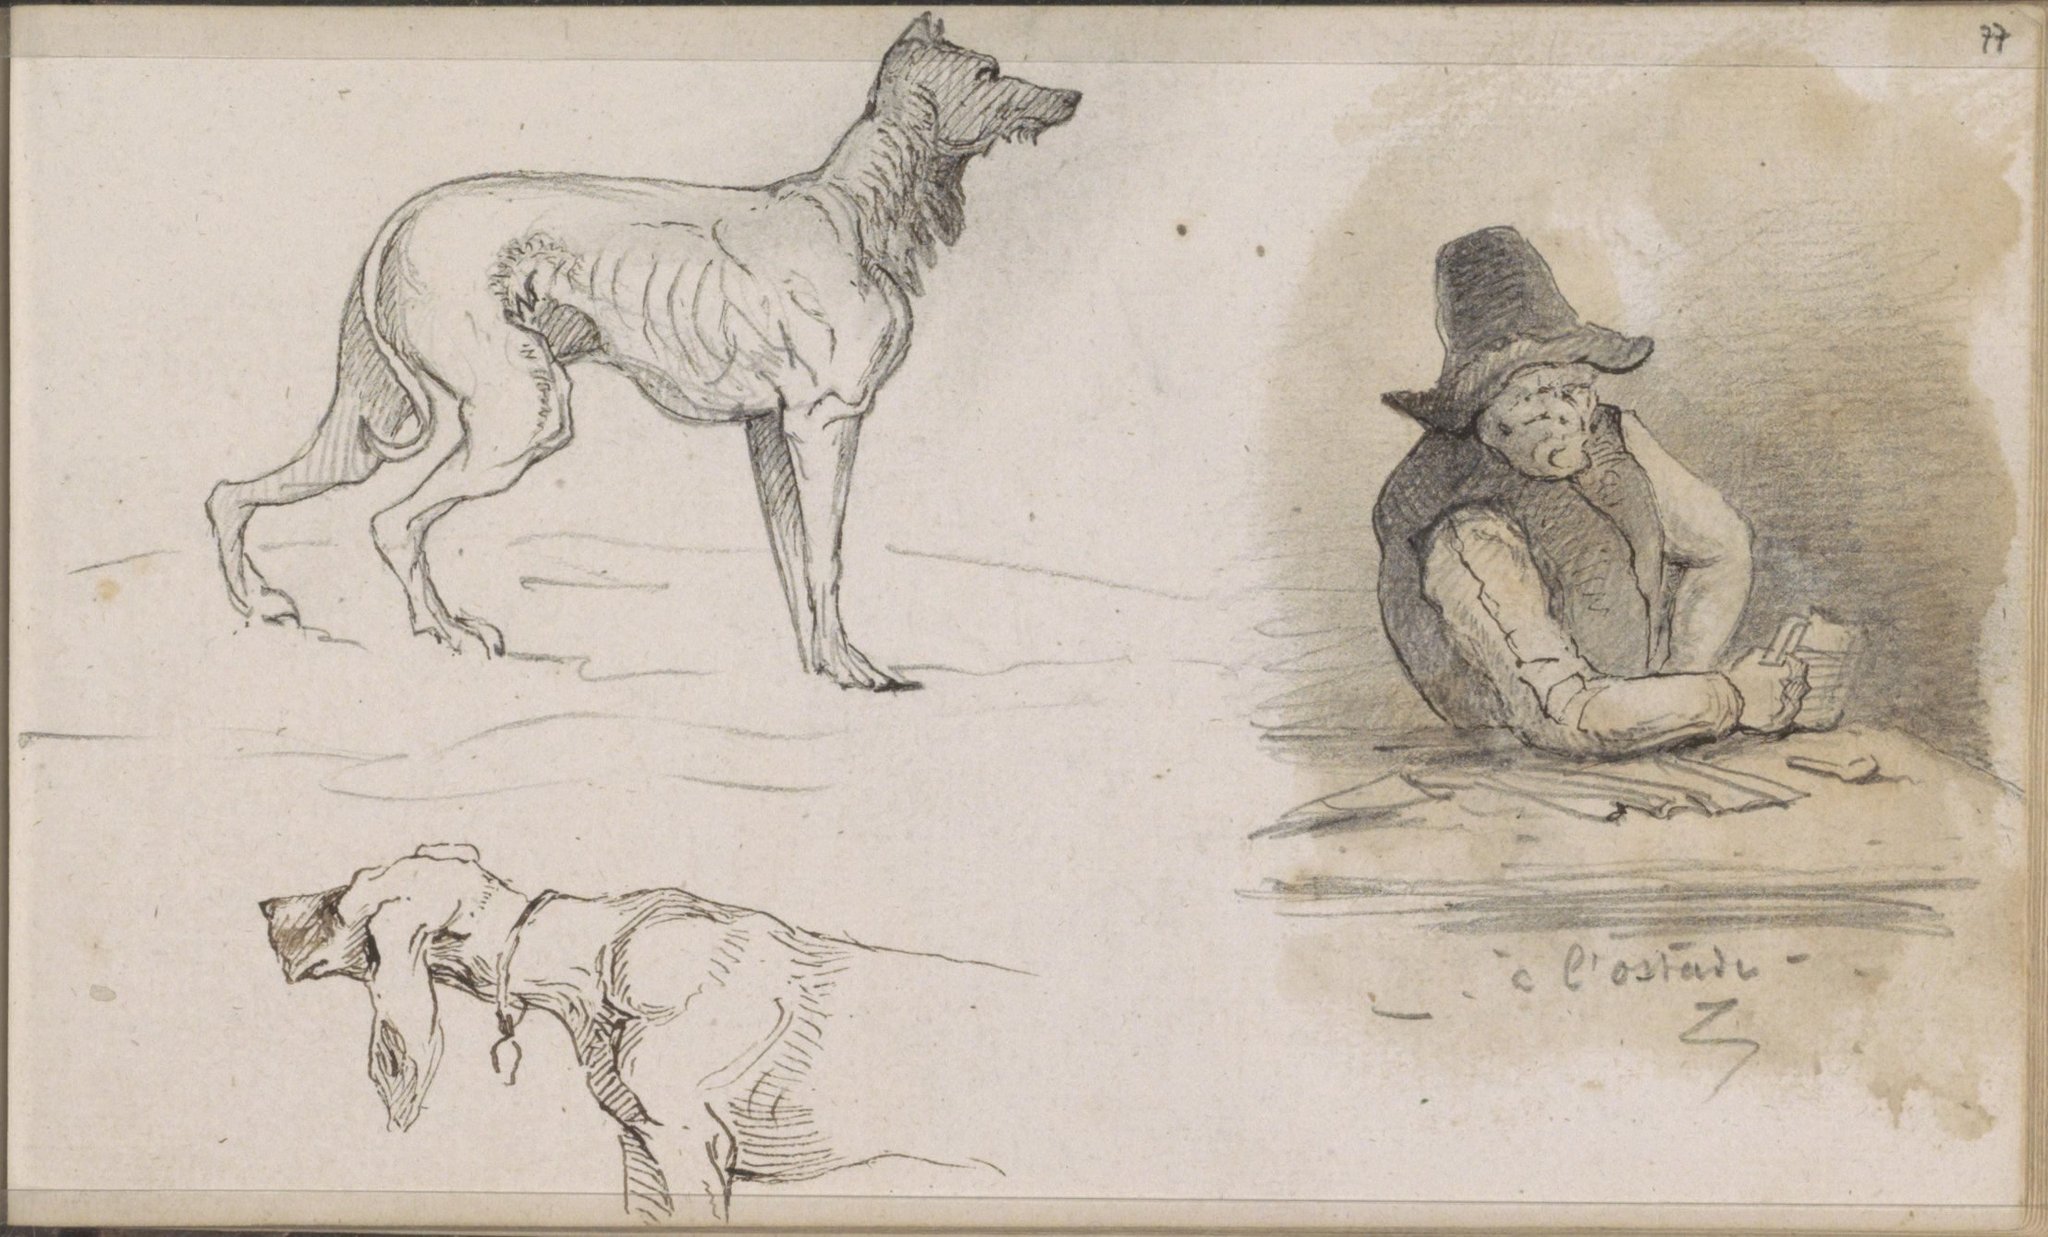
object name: sketchbook leaf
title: Honden en een man leunend op een tafel met een kroes in de hand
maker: johannes tavenraat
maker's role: draughtsman, painter, print maker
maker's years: 1809-1881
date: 1864-1880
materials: ink, paper, pencil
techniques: brush, pen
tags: adult man, mug, beaker, goblet, leaning figure, dog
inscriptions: annotation: ‘a l'ostade’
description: De schets van de man met de kroes in de hand is een kopie naar een werk van Adriaen van Ostade. Blad 77 recto uit een schetsboek met 98 bladen.